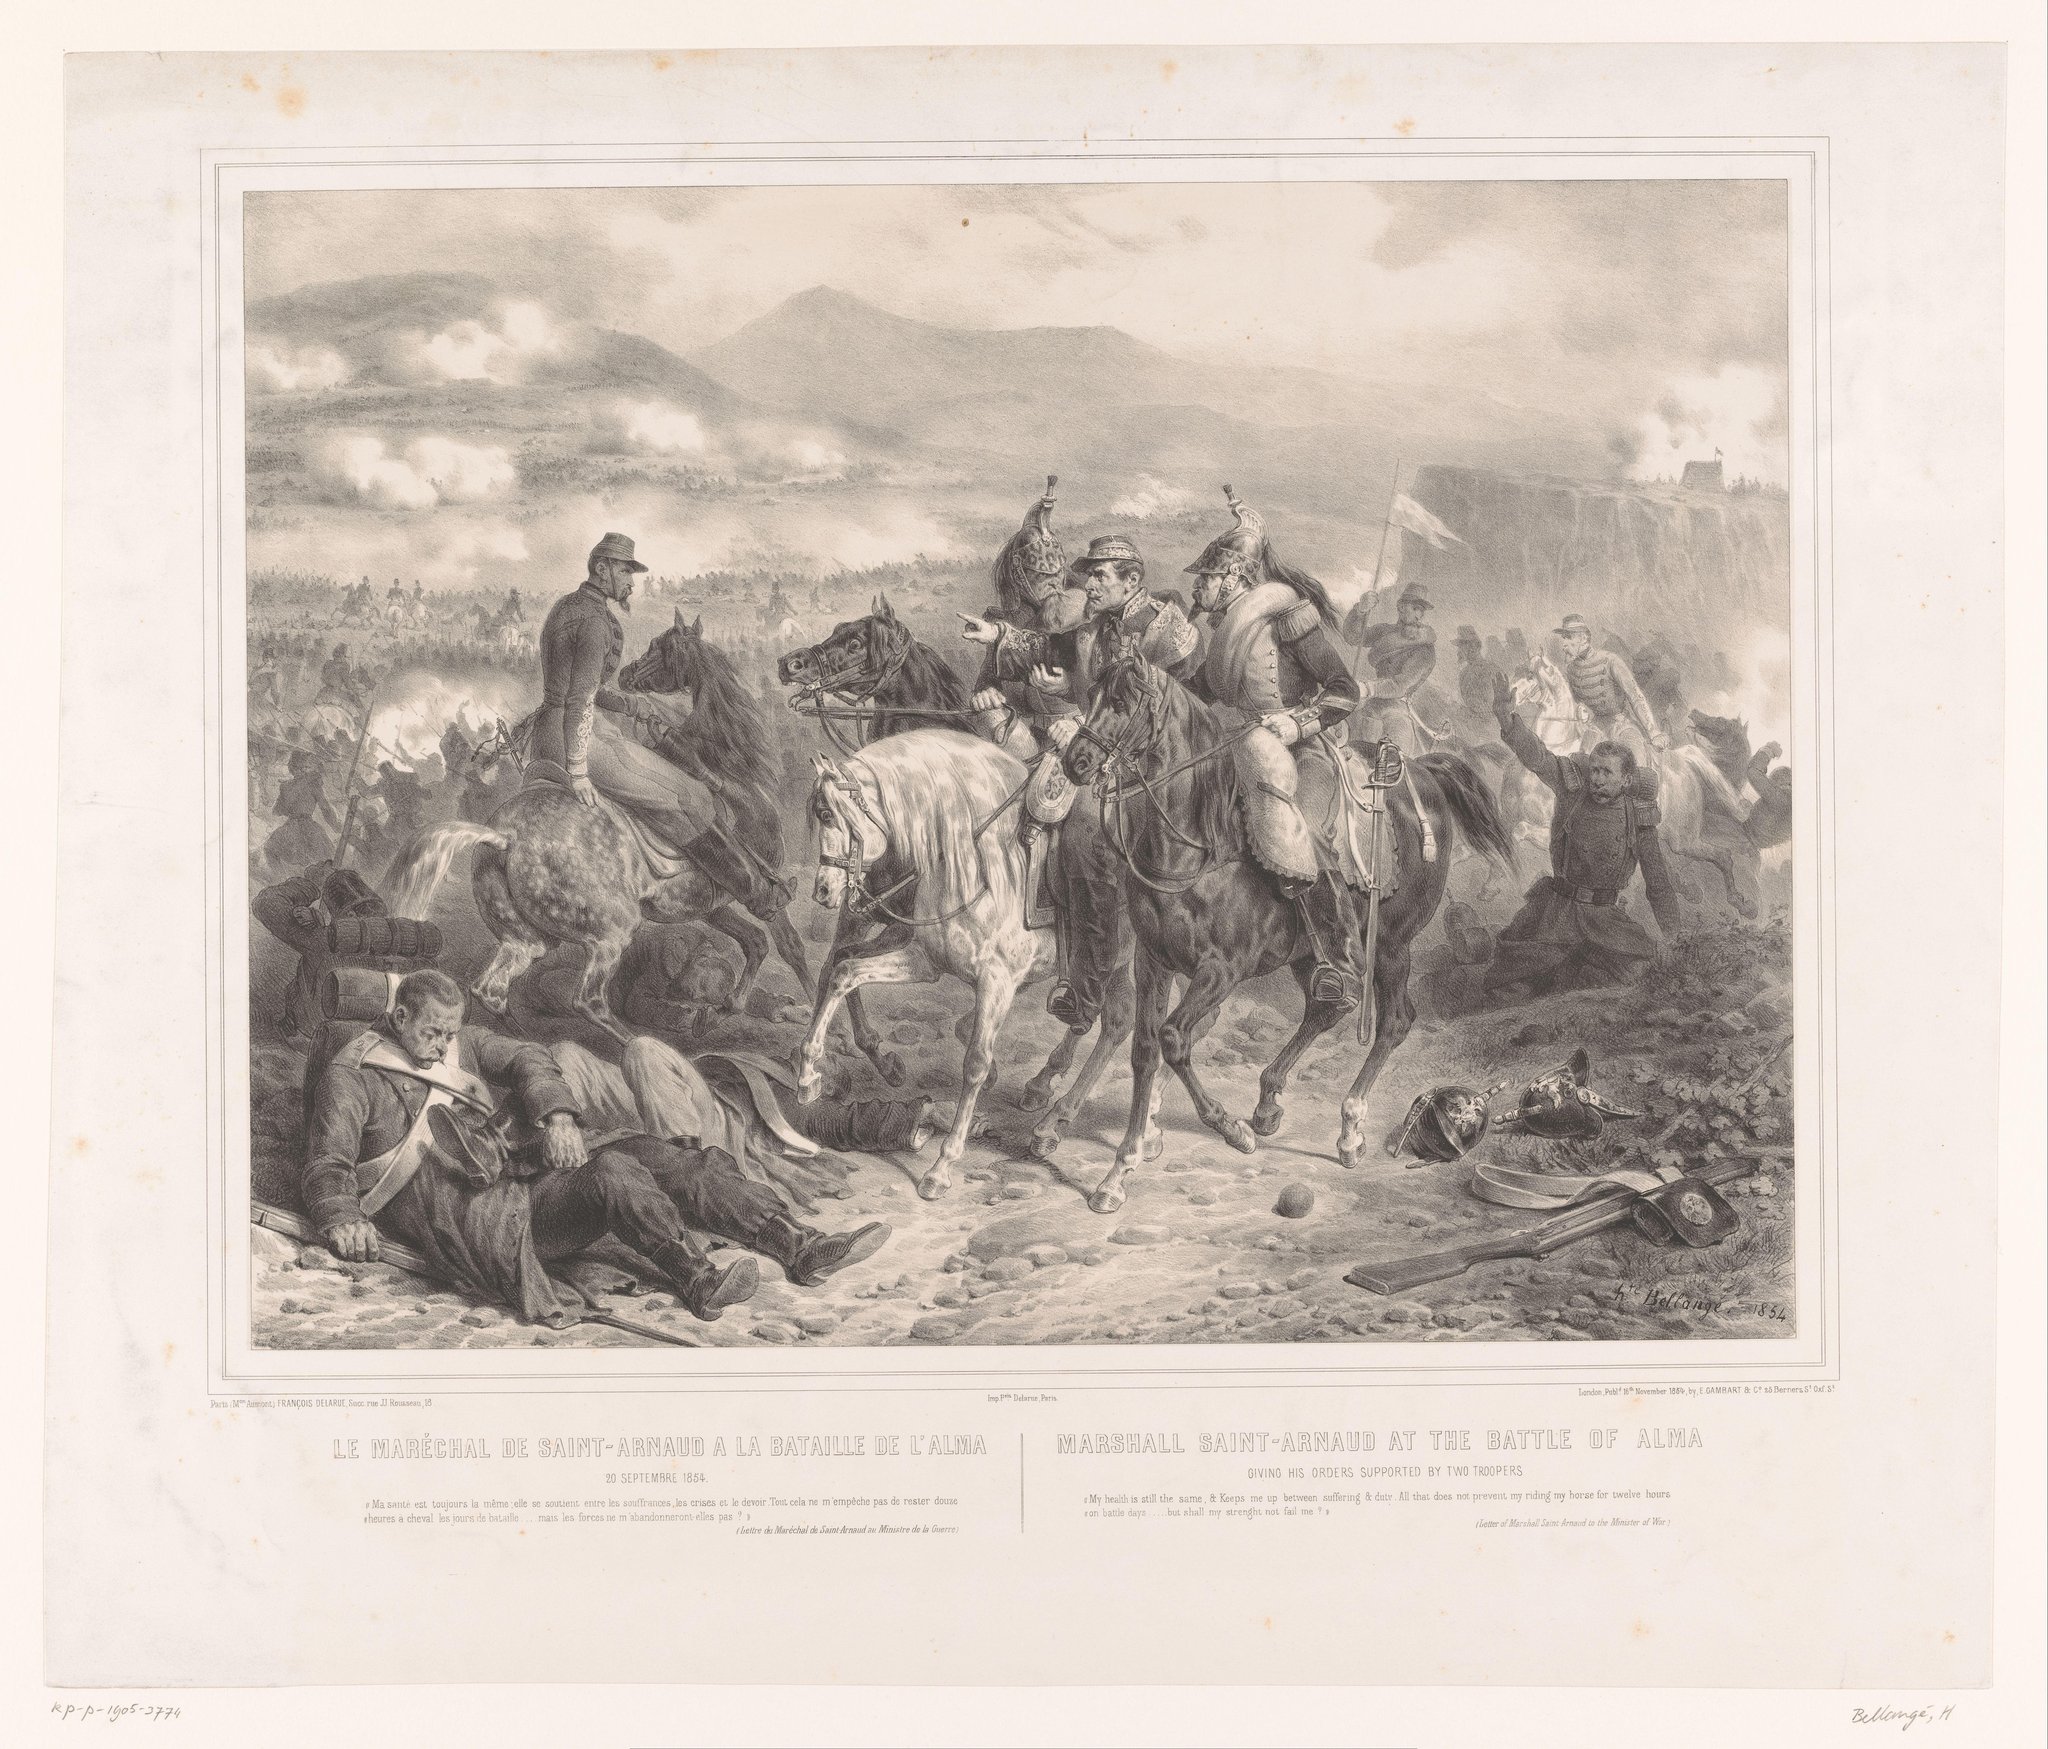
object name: print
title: Maarschalk De Saint-Arnaud tijdens de Slag aan de Alma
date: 1854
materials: paper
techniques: lithograph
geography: paris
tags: paris, historical persons, battle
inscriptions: collector's mark: Lugt 2228a